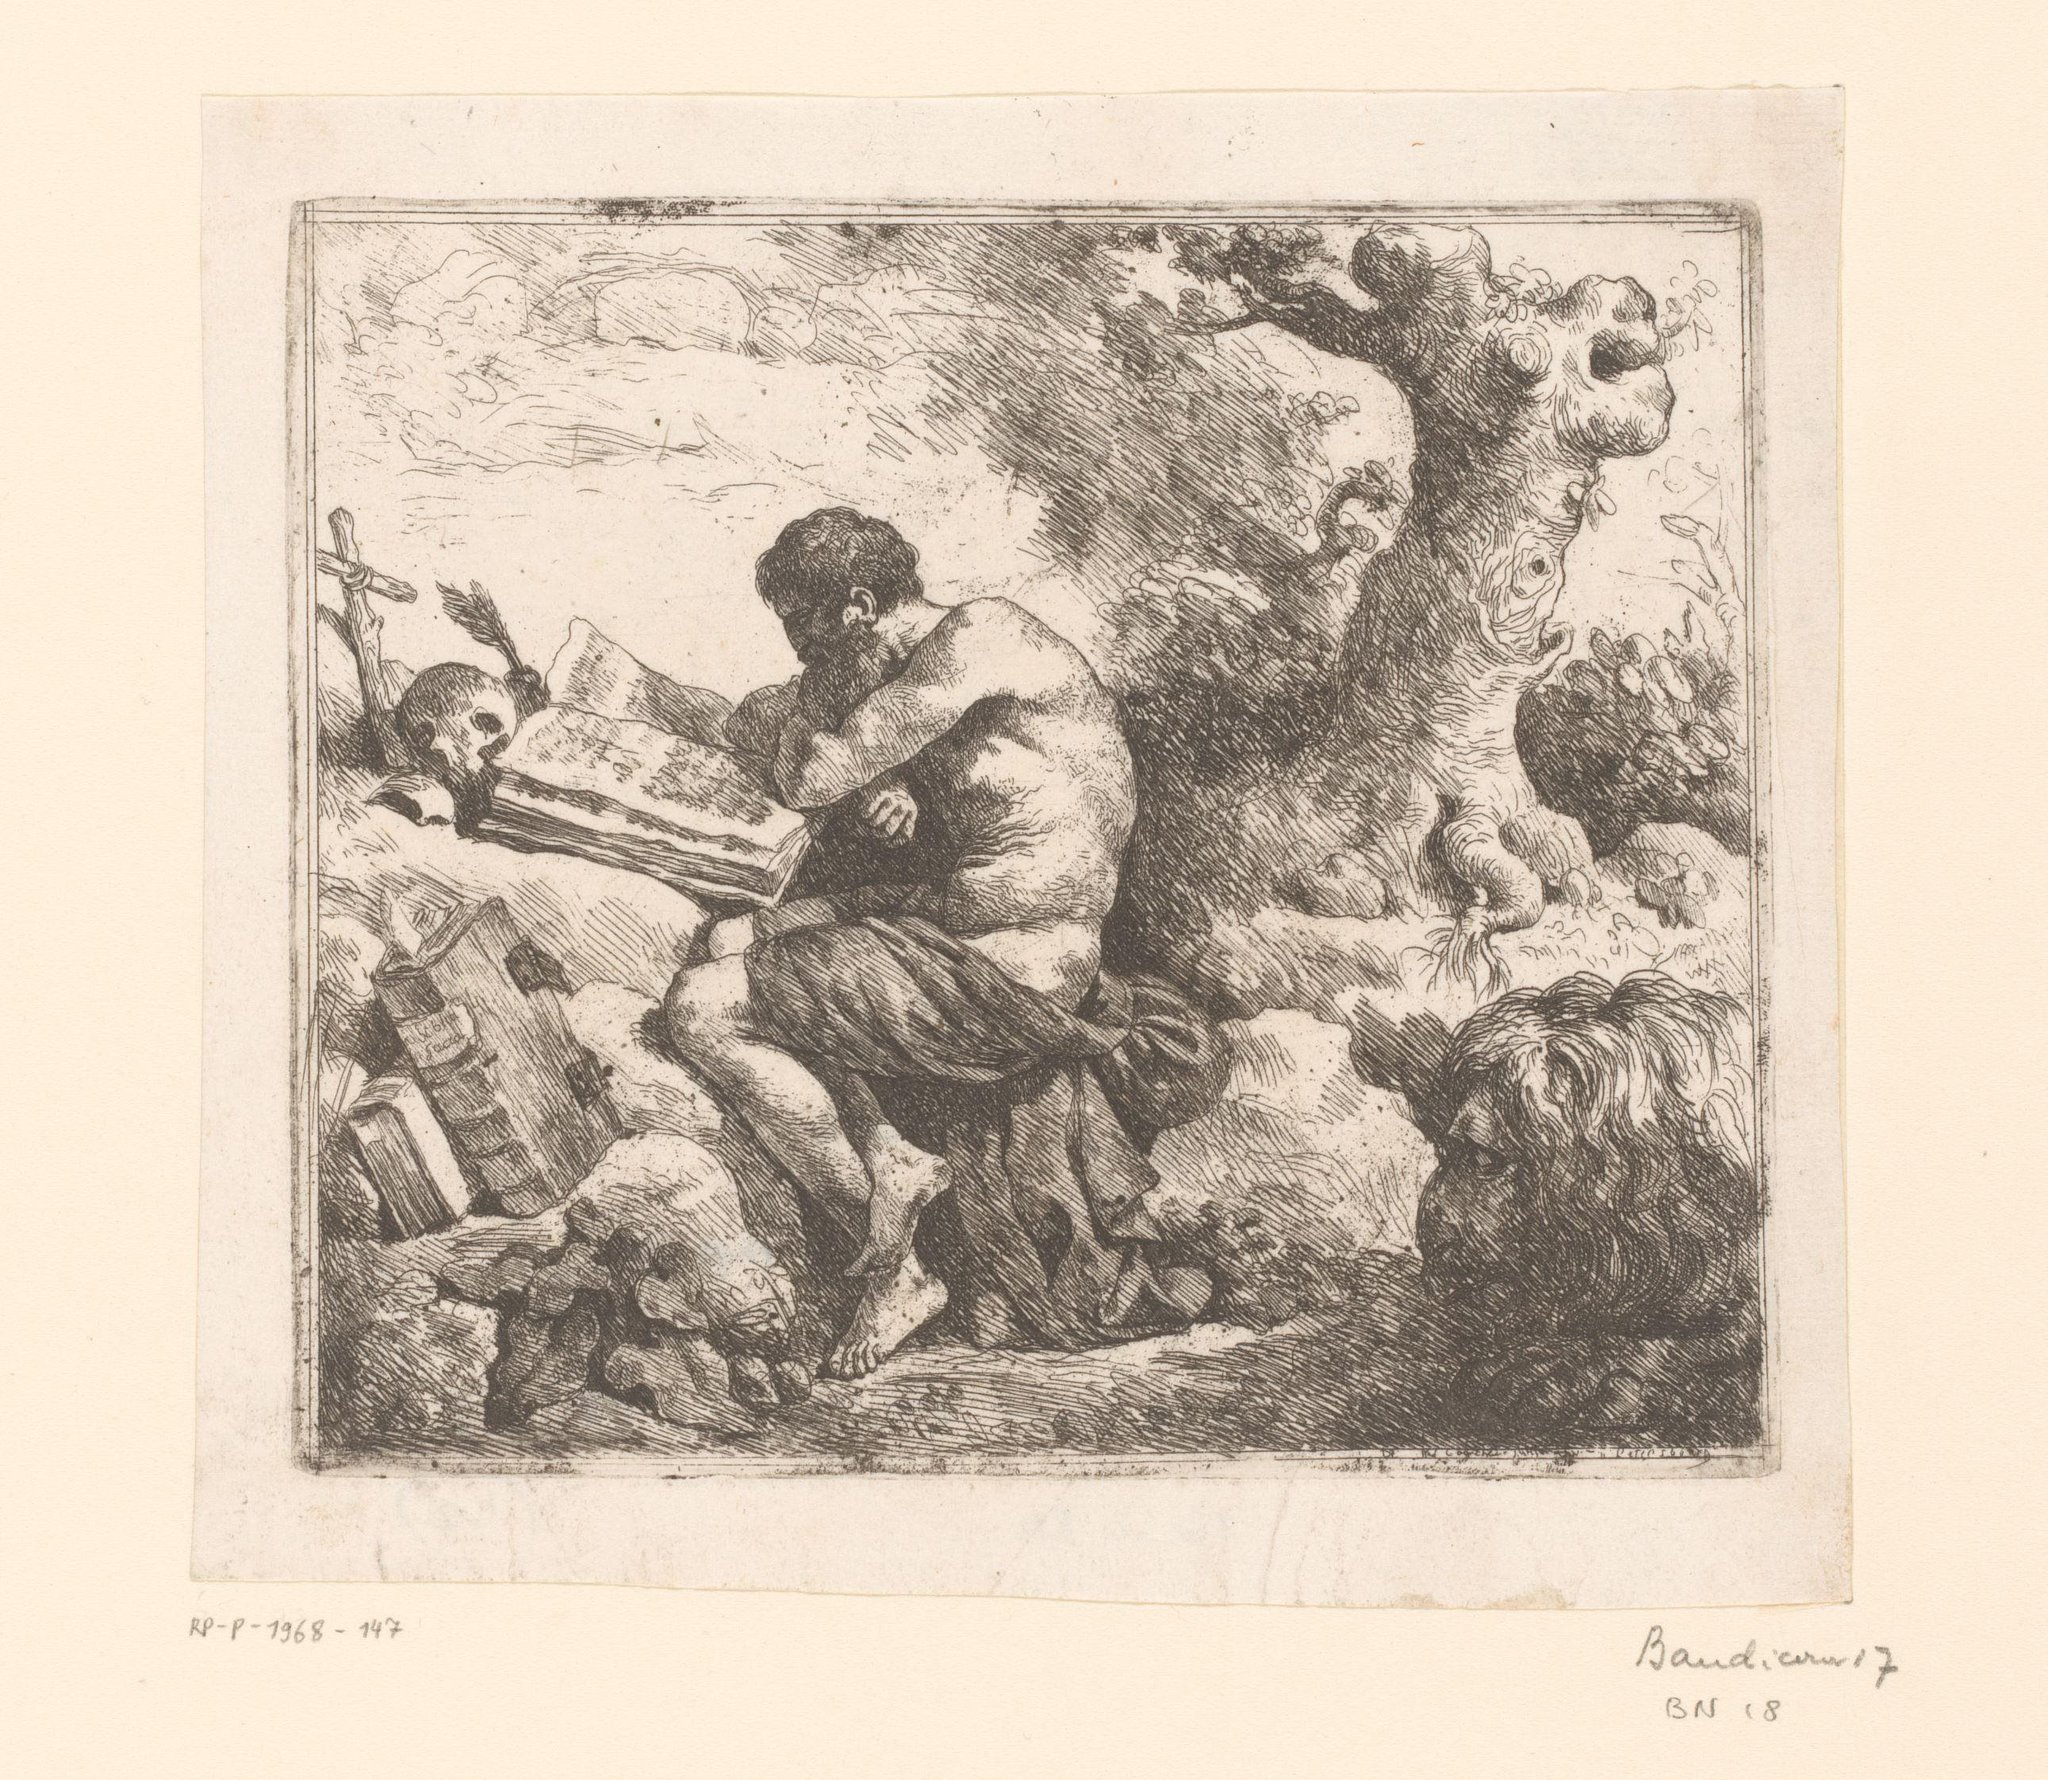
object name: print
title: Hiëronymus en de leeuw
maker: jean jacques ii lagrenée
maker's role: print maker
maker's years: 1739-1821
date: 1749-1821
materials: paper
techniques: engraving, etching, intaglio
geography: sint-petersburg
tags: st. jerome as hermit in a landscape, reading, beasts of prey, predatory animals: lion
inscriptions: collector's mark: Lugt 2760, collector's mark: Lugt 2228